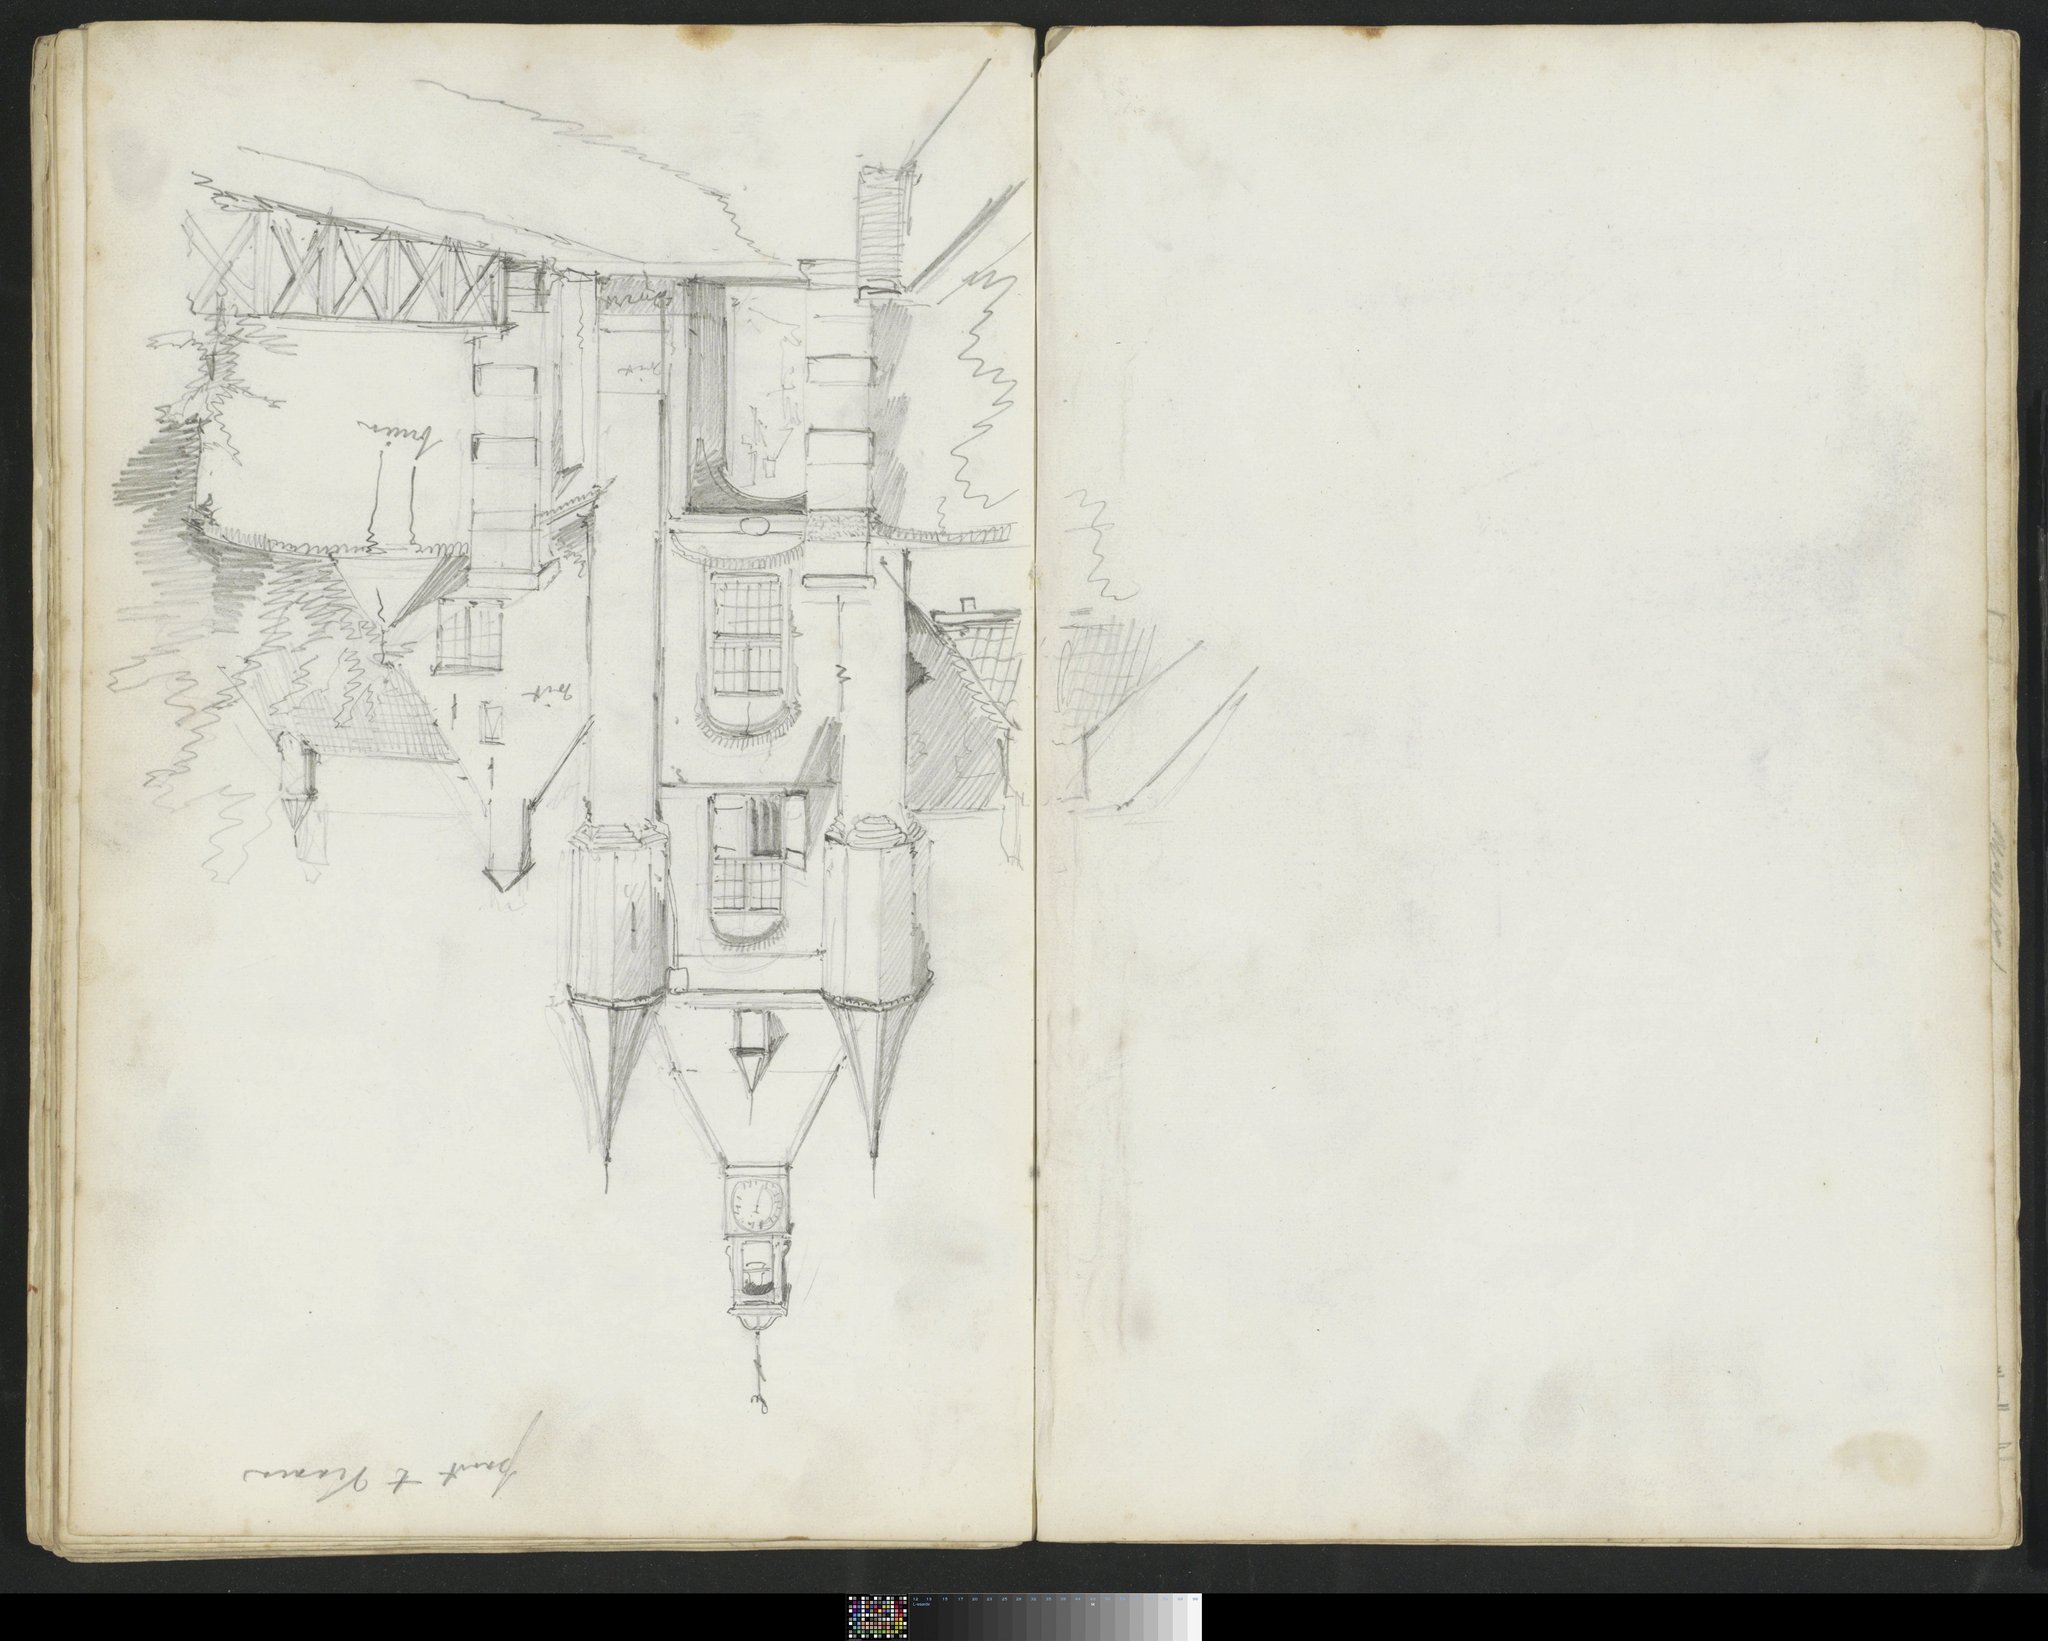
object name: sketchbook leaf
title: Lekpoort te Vianen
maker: willem koekkoek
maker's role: draughtsman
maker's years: 1839-1895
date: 1849-1895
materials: paper, pencil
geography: vianen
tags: city-gate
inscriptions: annotation: ‘poort te Vianen’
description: Blad 33 verso en 34 recto uit een schetsboek met 42 bladen.